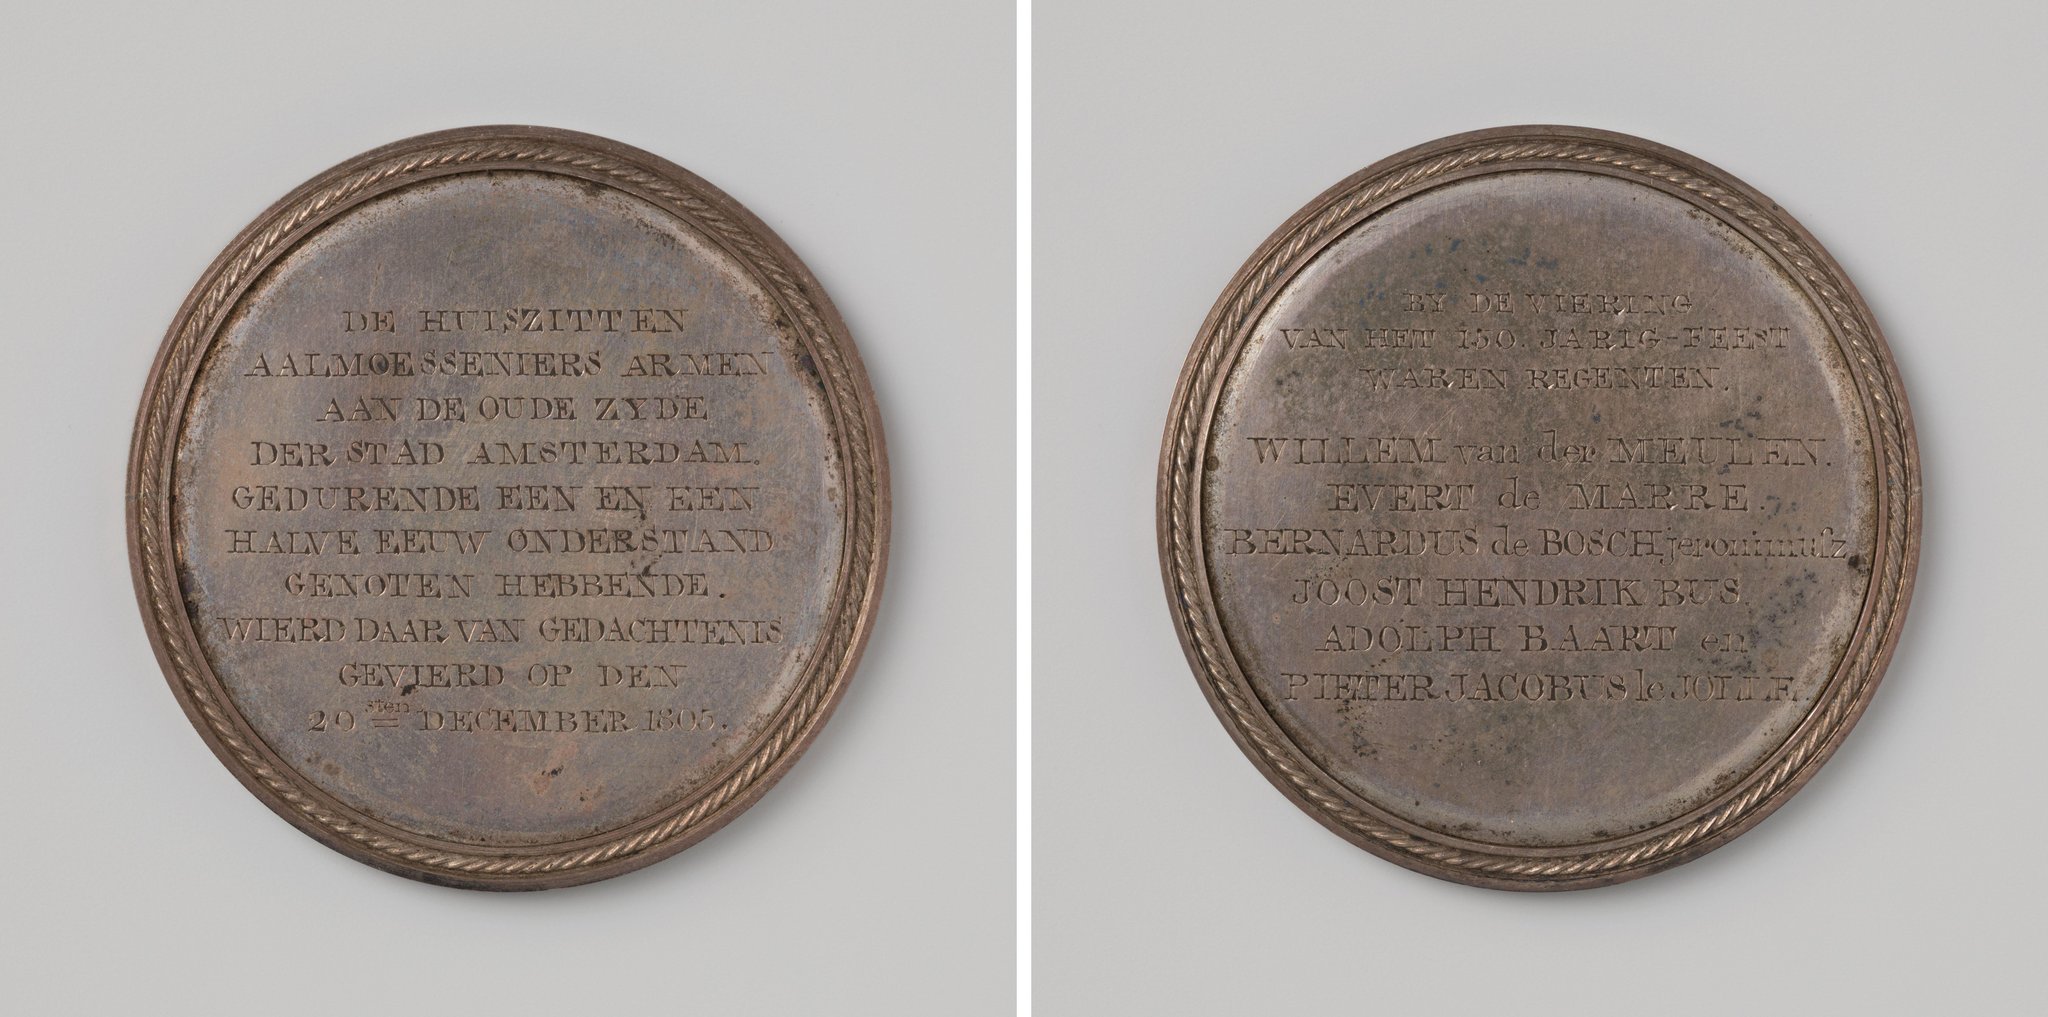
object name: history medal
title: 150-Jarig bestaan van het Huiszitten-aalmoezeniershuis aan de Oude Zijde te Amsterdam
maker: Anonymous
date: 1805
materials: silver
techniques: engraving, striking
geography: amsterdam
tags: amsterdam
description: Zilveren penning. Voorzijde: opschrift binnen kabelrand. Keerzijde: opschrift binnen kabelrand.